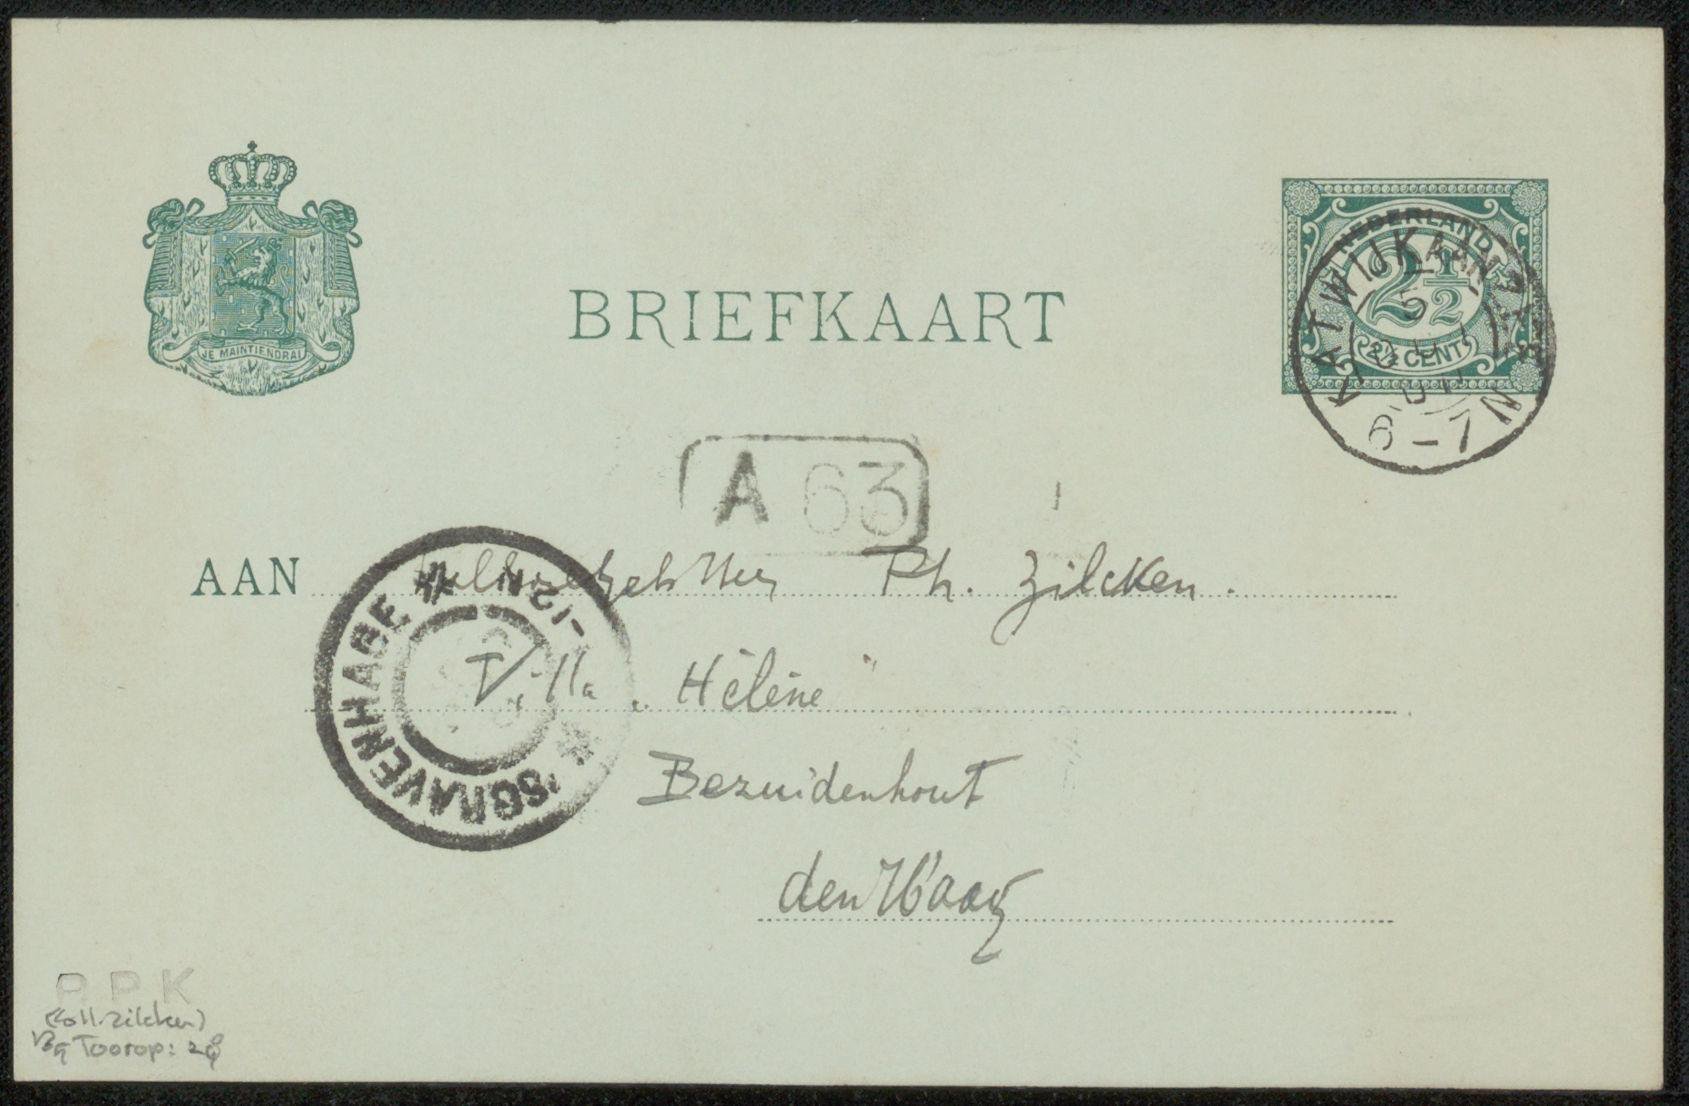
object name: postcard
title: Briefkaart aan Philip Zilcken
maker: jan toorop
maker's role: draughtsman, painter, print maker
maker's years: 1858-1928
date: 1900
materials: cardboard, ink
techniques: pen, writing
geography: katwijk aan zee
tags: voorburg, renée hélène laure zilcken, painter, draughtsman, philip zilcken, the graphic arts, anonymous historical person portrayed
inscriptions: collector's mark: ‘RPK’